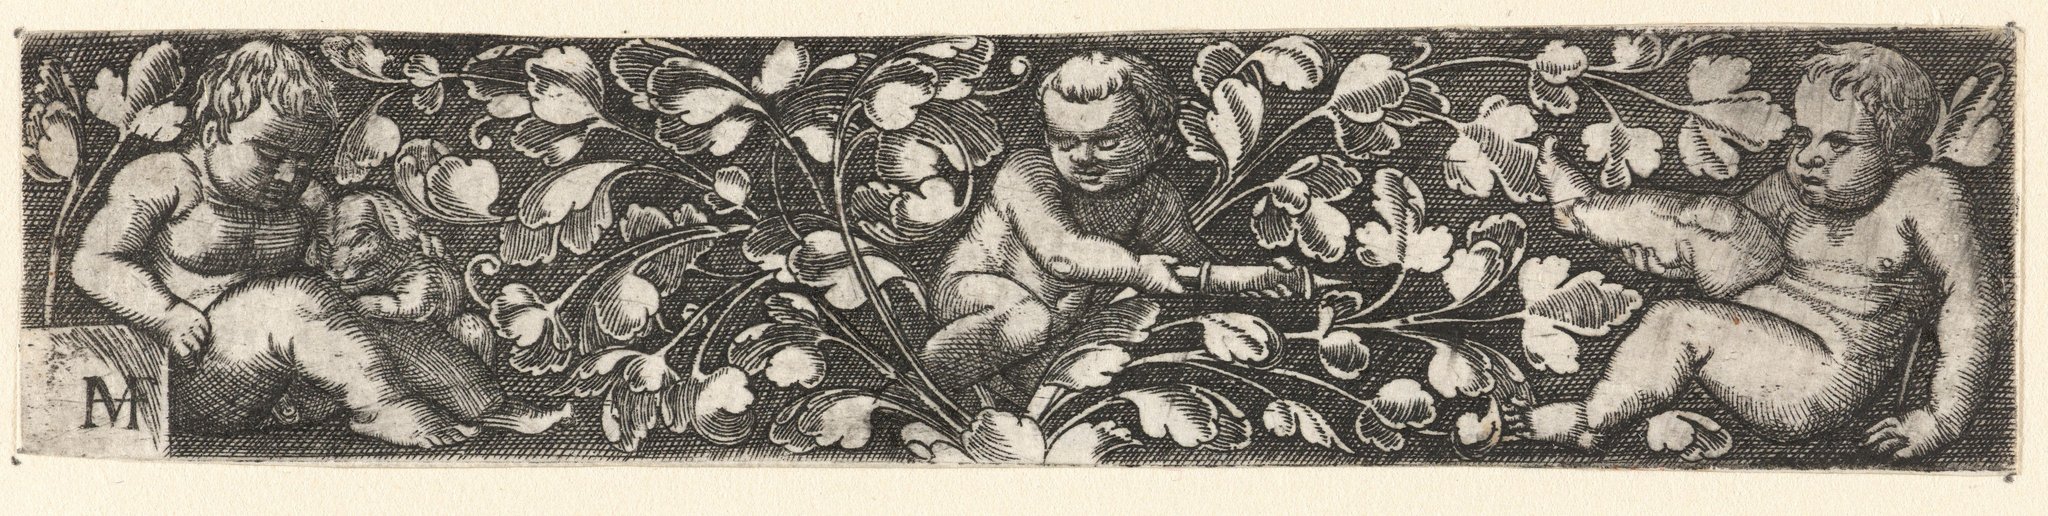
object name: ornament print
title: Fries met drie kinderen, zittend tussen bladranken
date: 1500-1600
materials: paper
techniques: engraving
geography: germany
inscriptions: collector's mark: Lugt 240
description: Het kind links heeft een hondje bij zich. Gearceerde achtergrond.